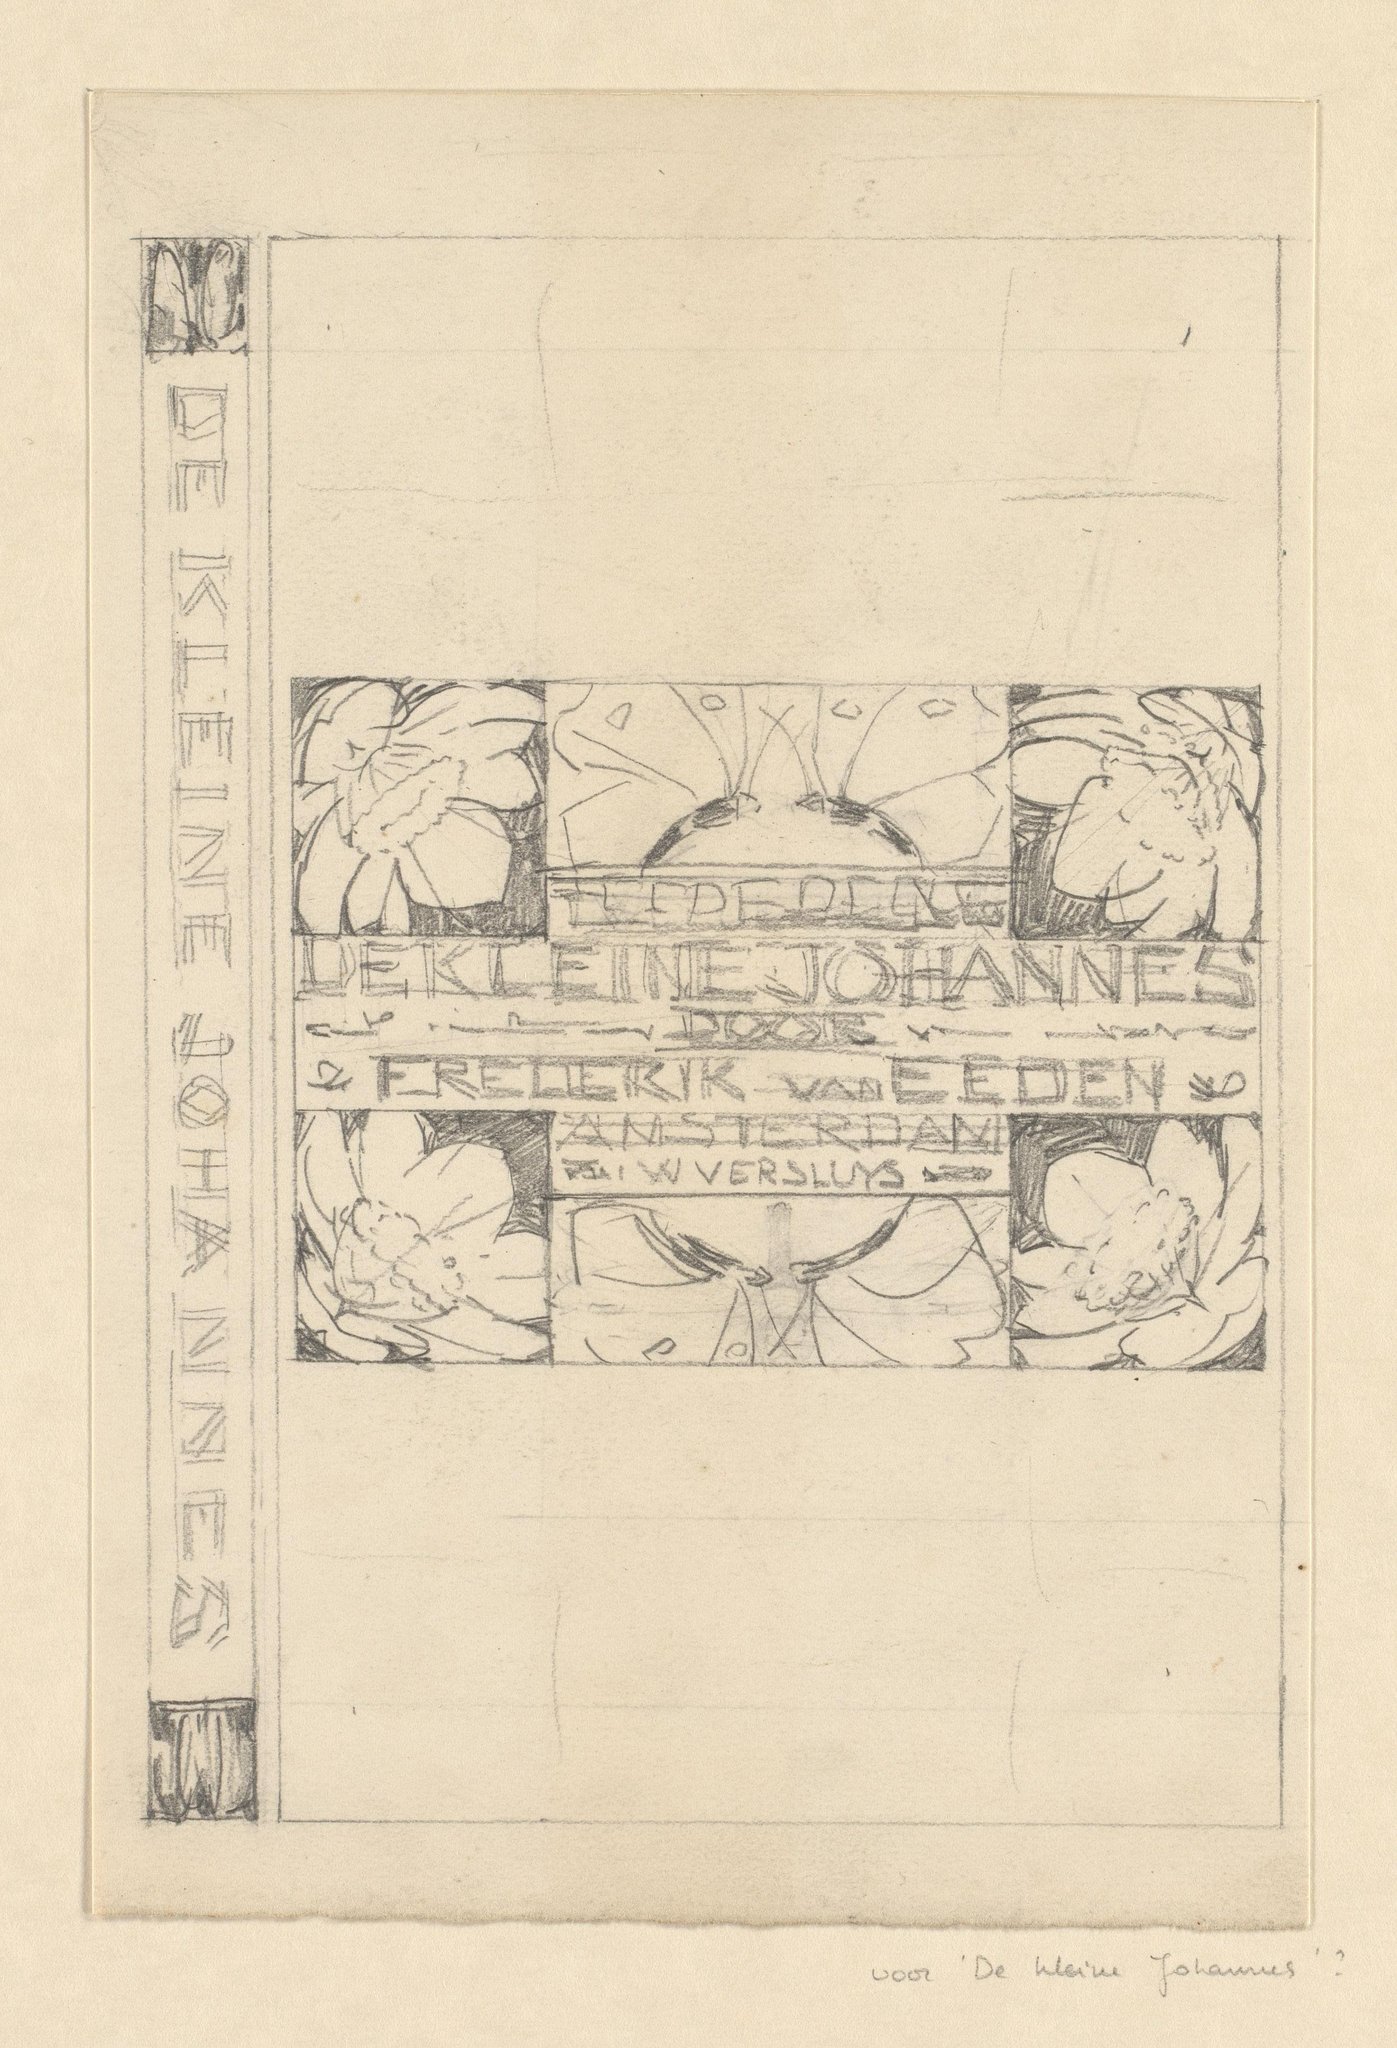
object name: titelblad, titelpagina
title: Ontwerp voor een titelpagina voor: Frederik van Eeden, De kleine Johannes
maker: edzard koning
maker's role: draughtsman, print maker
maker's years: 1869-1954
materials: paper, pencil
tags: flowers, (van eeden, de kleine johannes) specific works of literature (with author, title), insects: butterfly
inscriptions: collector's mark: Lugt 2228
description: Ontwerp voor: Eeden, Frederik van. De kleine Johannes. Den Haag: Mouton & Co., 1898. Niet gebruikt in de definitieve uitgave.